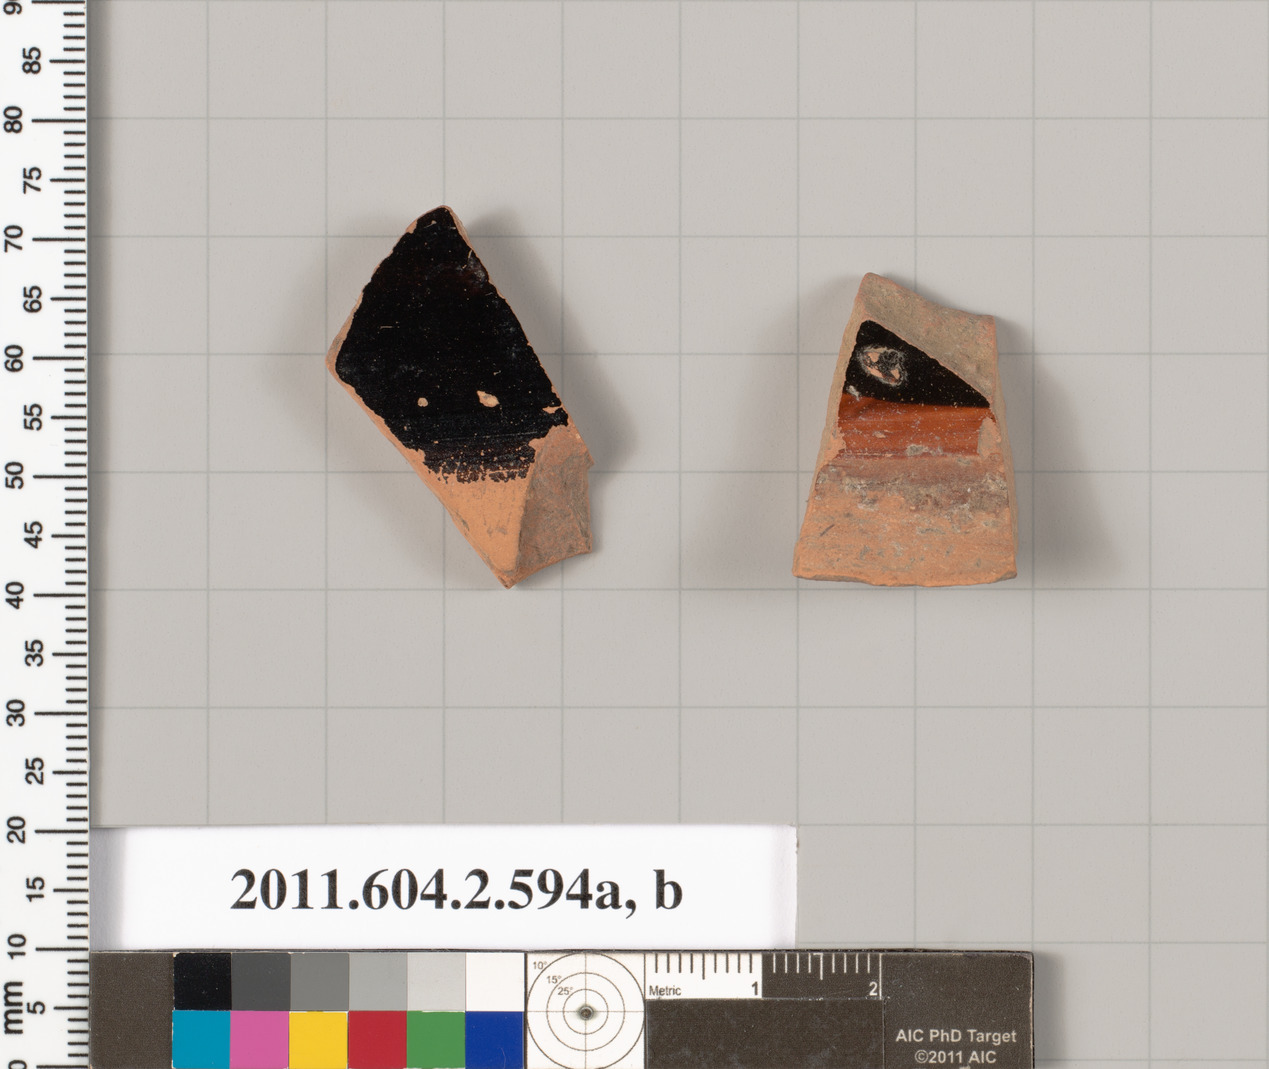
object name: column krater fragment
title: Terracotta fragments of column-kraters (bowls for mixing wine and water)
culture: greek, attic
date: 470-440 BCE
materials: terracotta